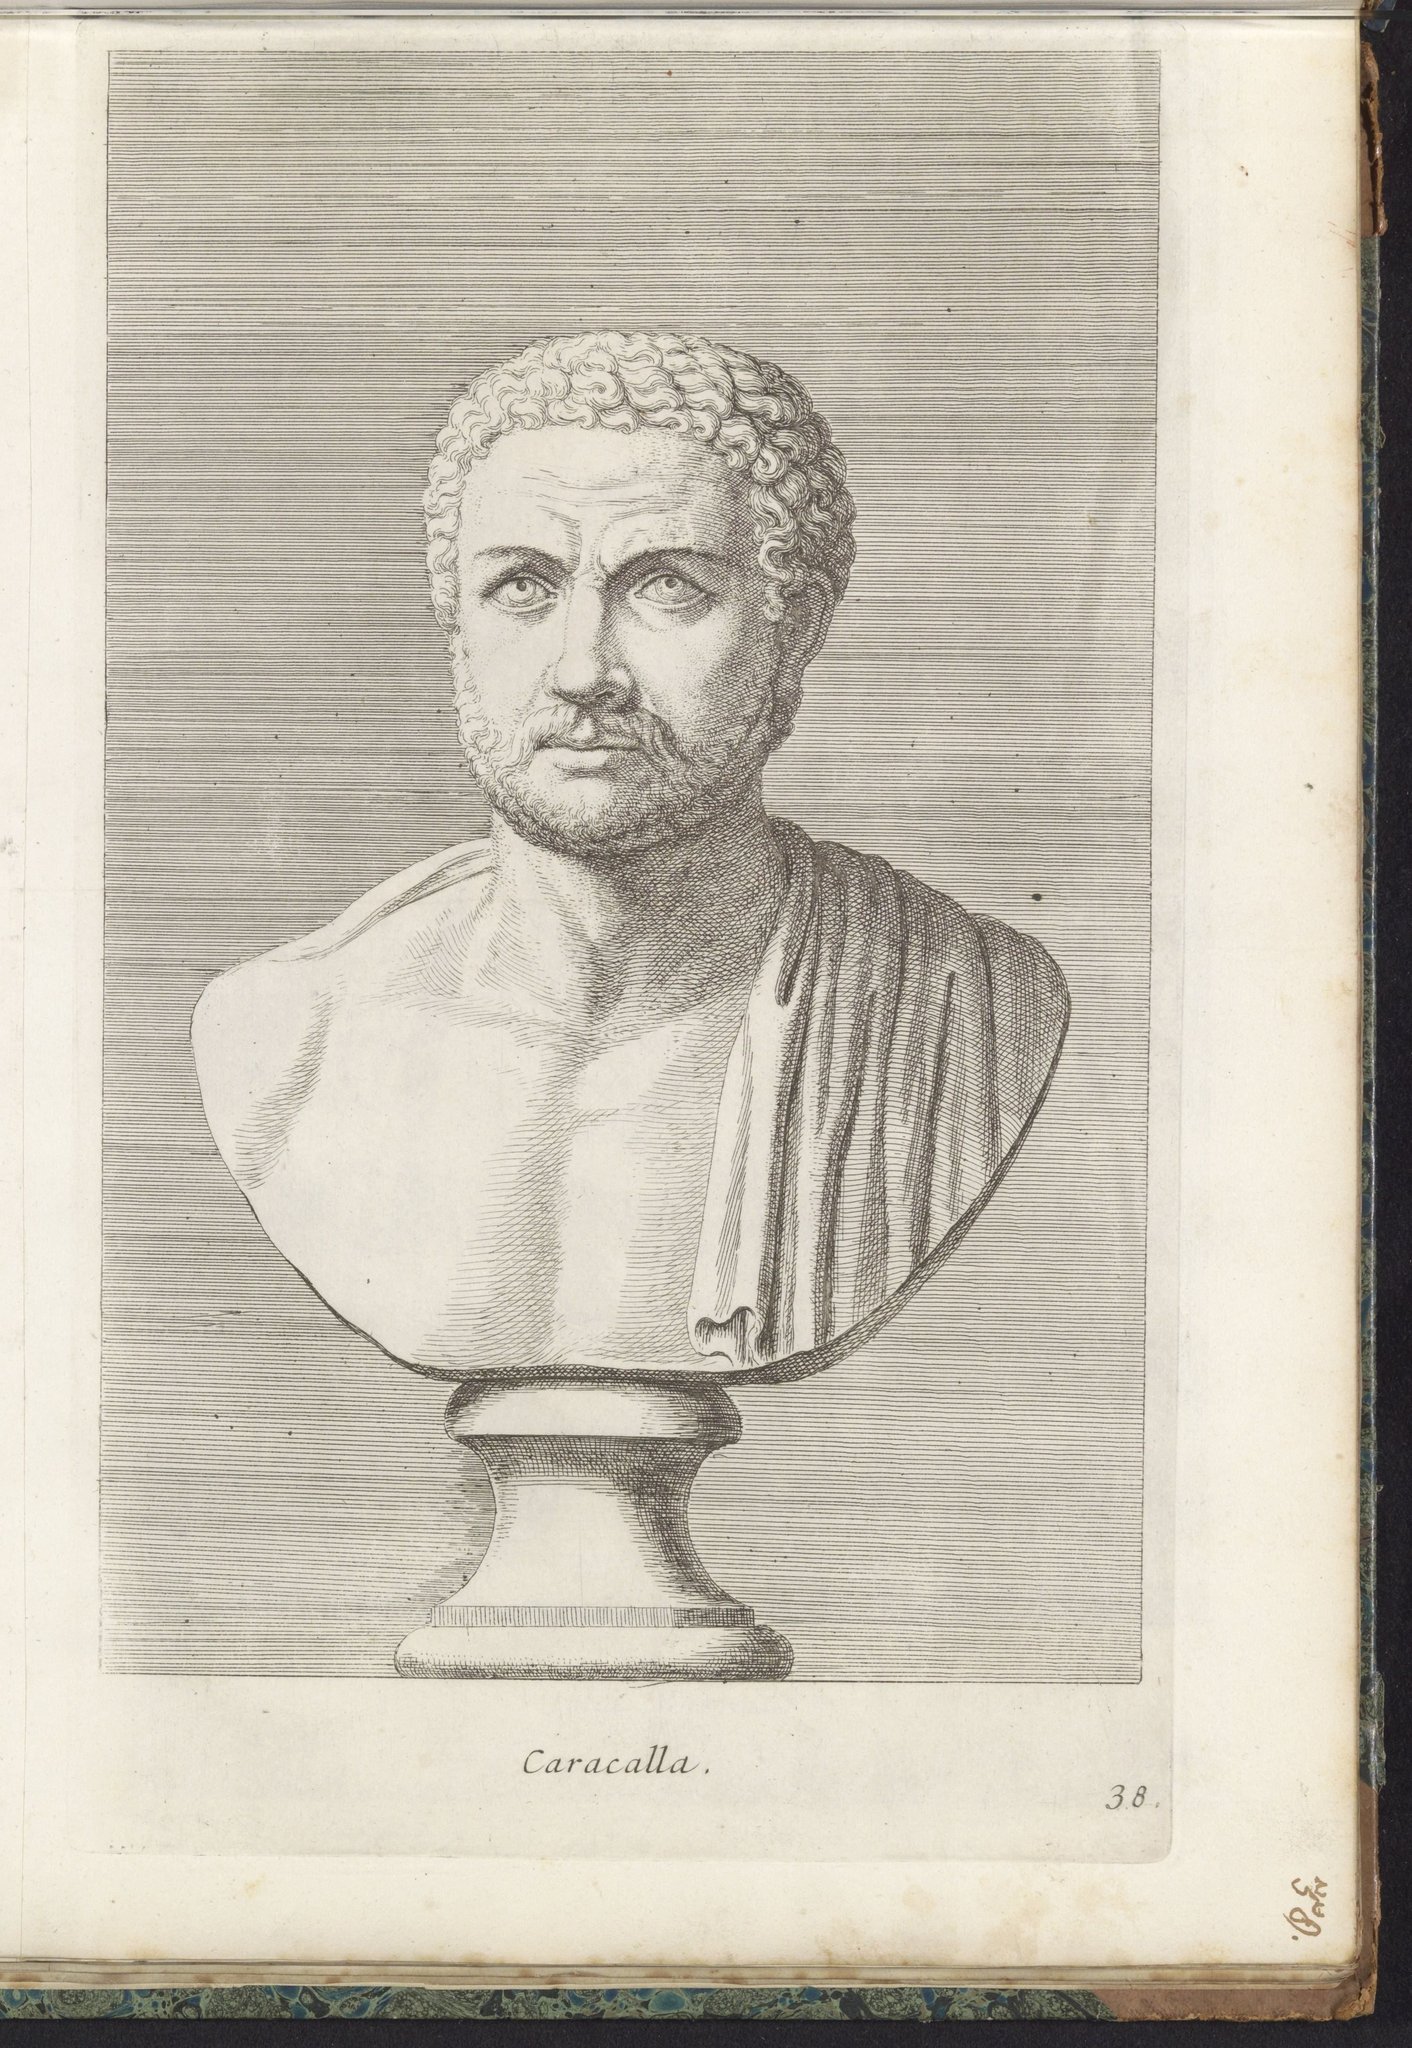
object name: print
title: Buste van keizer Caracalla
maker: hubert quellinus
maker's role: print maker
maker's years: 1619-1687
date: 1646-1670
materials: paper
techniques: engraving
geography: antwerp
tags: piece of sculpture, reproduction of a piece of sculpture, male persons from classical history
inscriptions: number: ‘58’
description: Klassieke buste van een bebaarde man met een deels ontbloot bovenlijf. De prent maakt deel uit van een album met een serie prenten naar de sculpturen in de verzameling van Gerard Reynst.